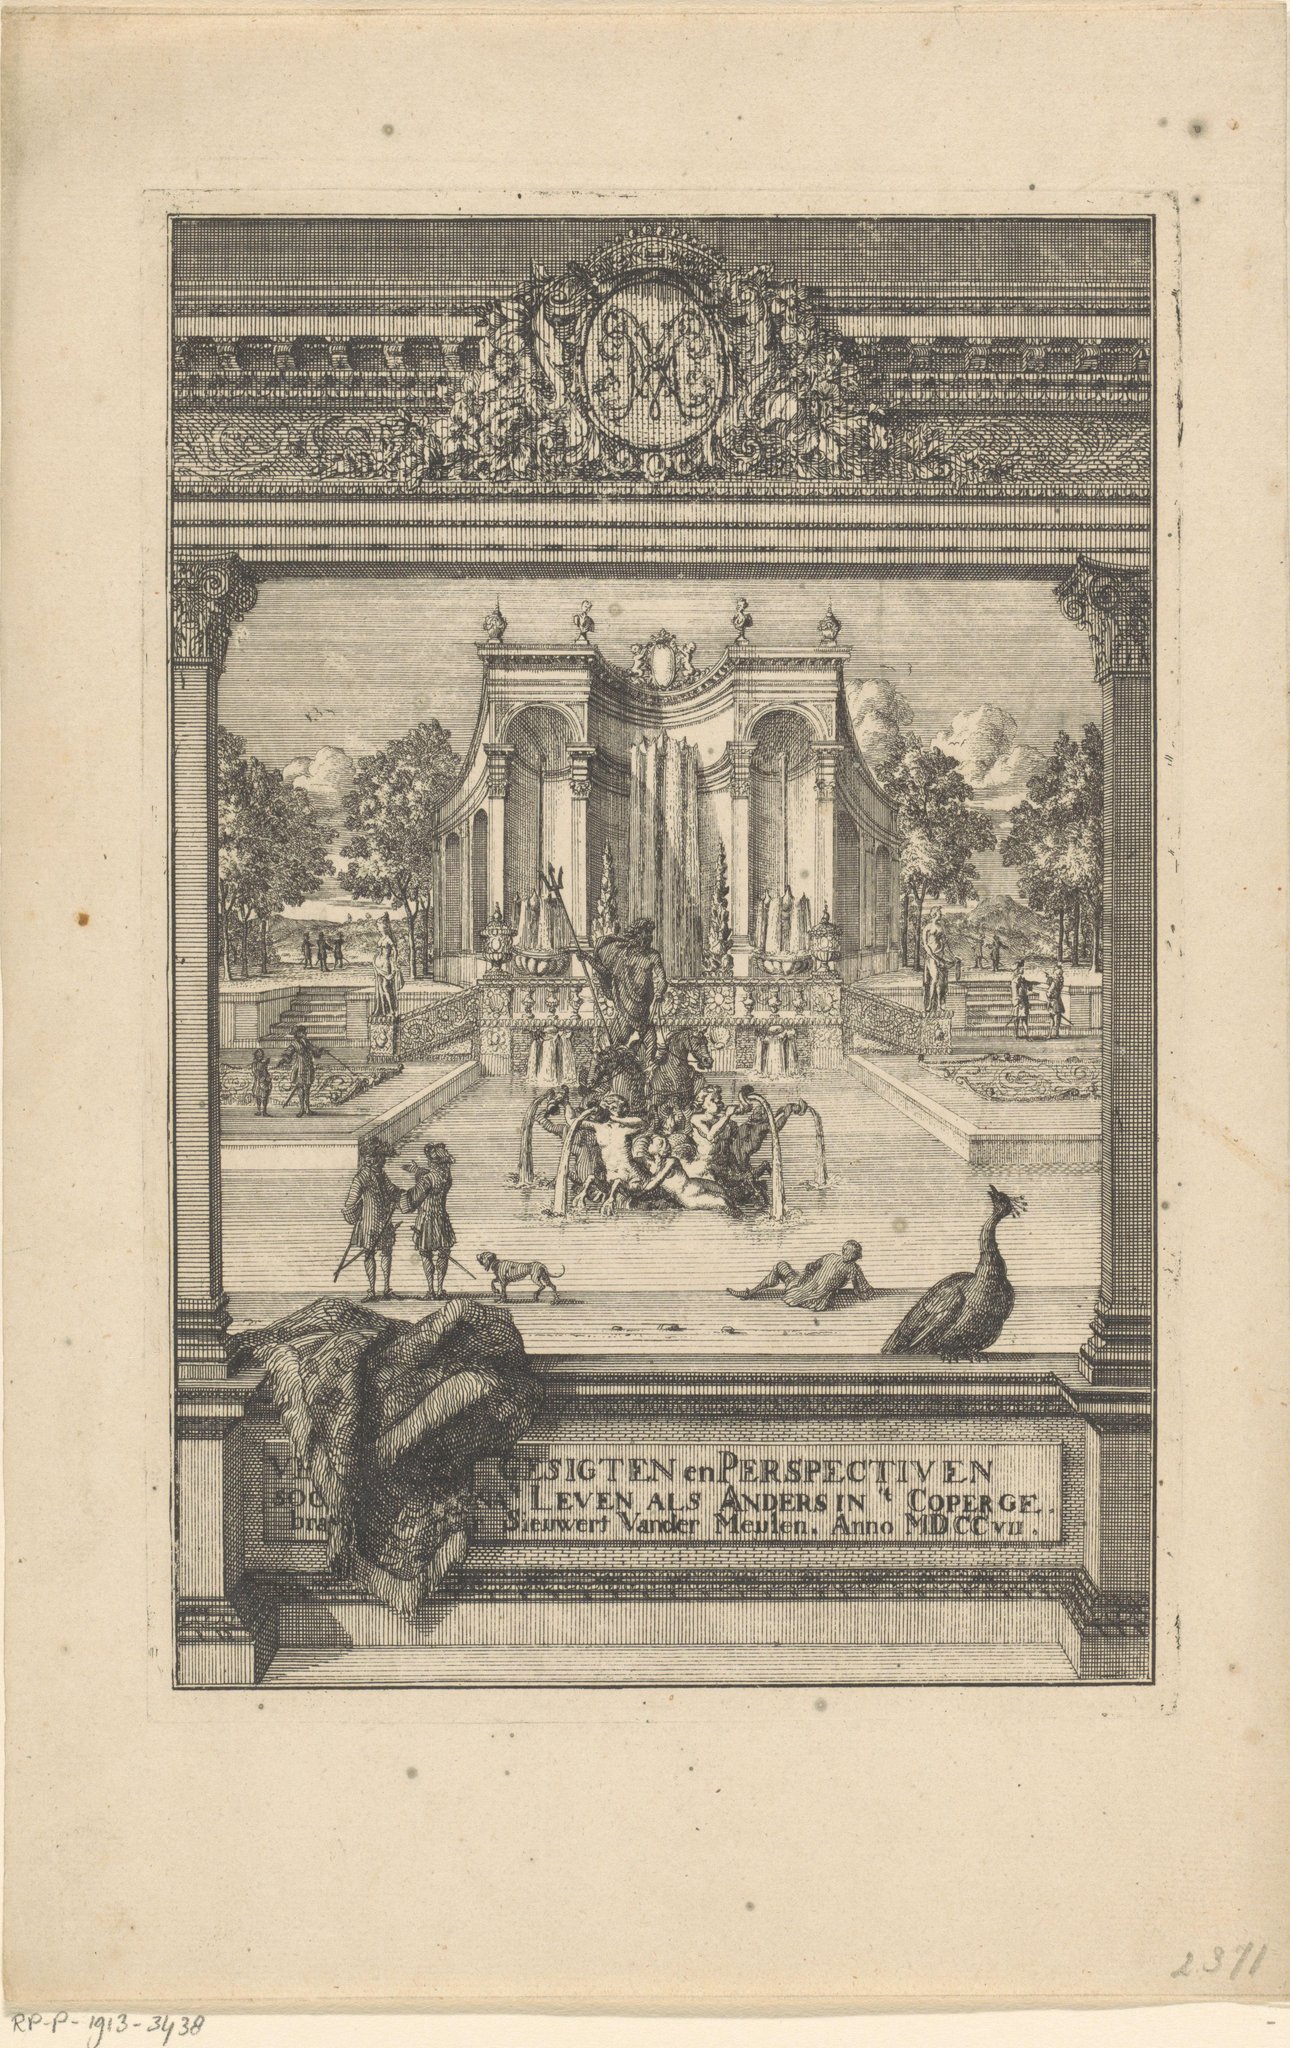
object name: print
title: Neptunusfontein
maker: sieuwert van der meulen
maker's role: draughtsman, print maker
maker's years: 1683-1730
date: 1707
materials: paper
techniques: etching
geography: netherlands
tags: (story of) neptune (poseidon), french or architectonic garden; formal garden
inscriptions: collector's mark: Lugt 2228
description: Een fontein van Neptunus op zijn wagen omringd door waterspuwende tritons. In de tuin enkele figuren. De voorstelling wordt omlijst door zuilen. Midden boven een monogram met de letter M. Op de vensterbank een tapijt en een pauw.